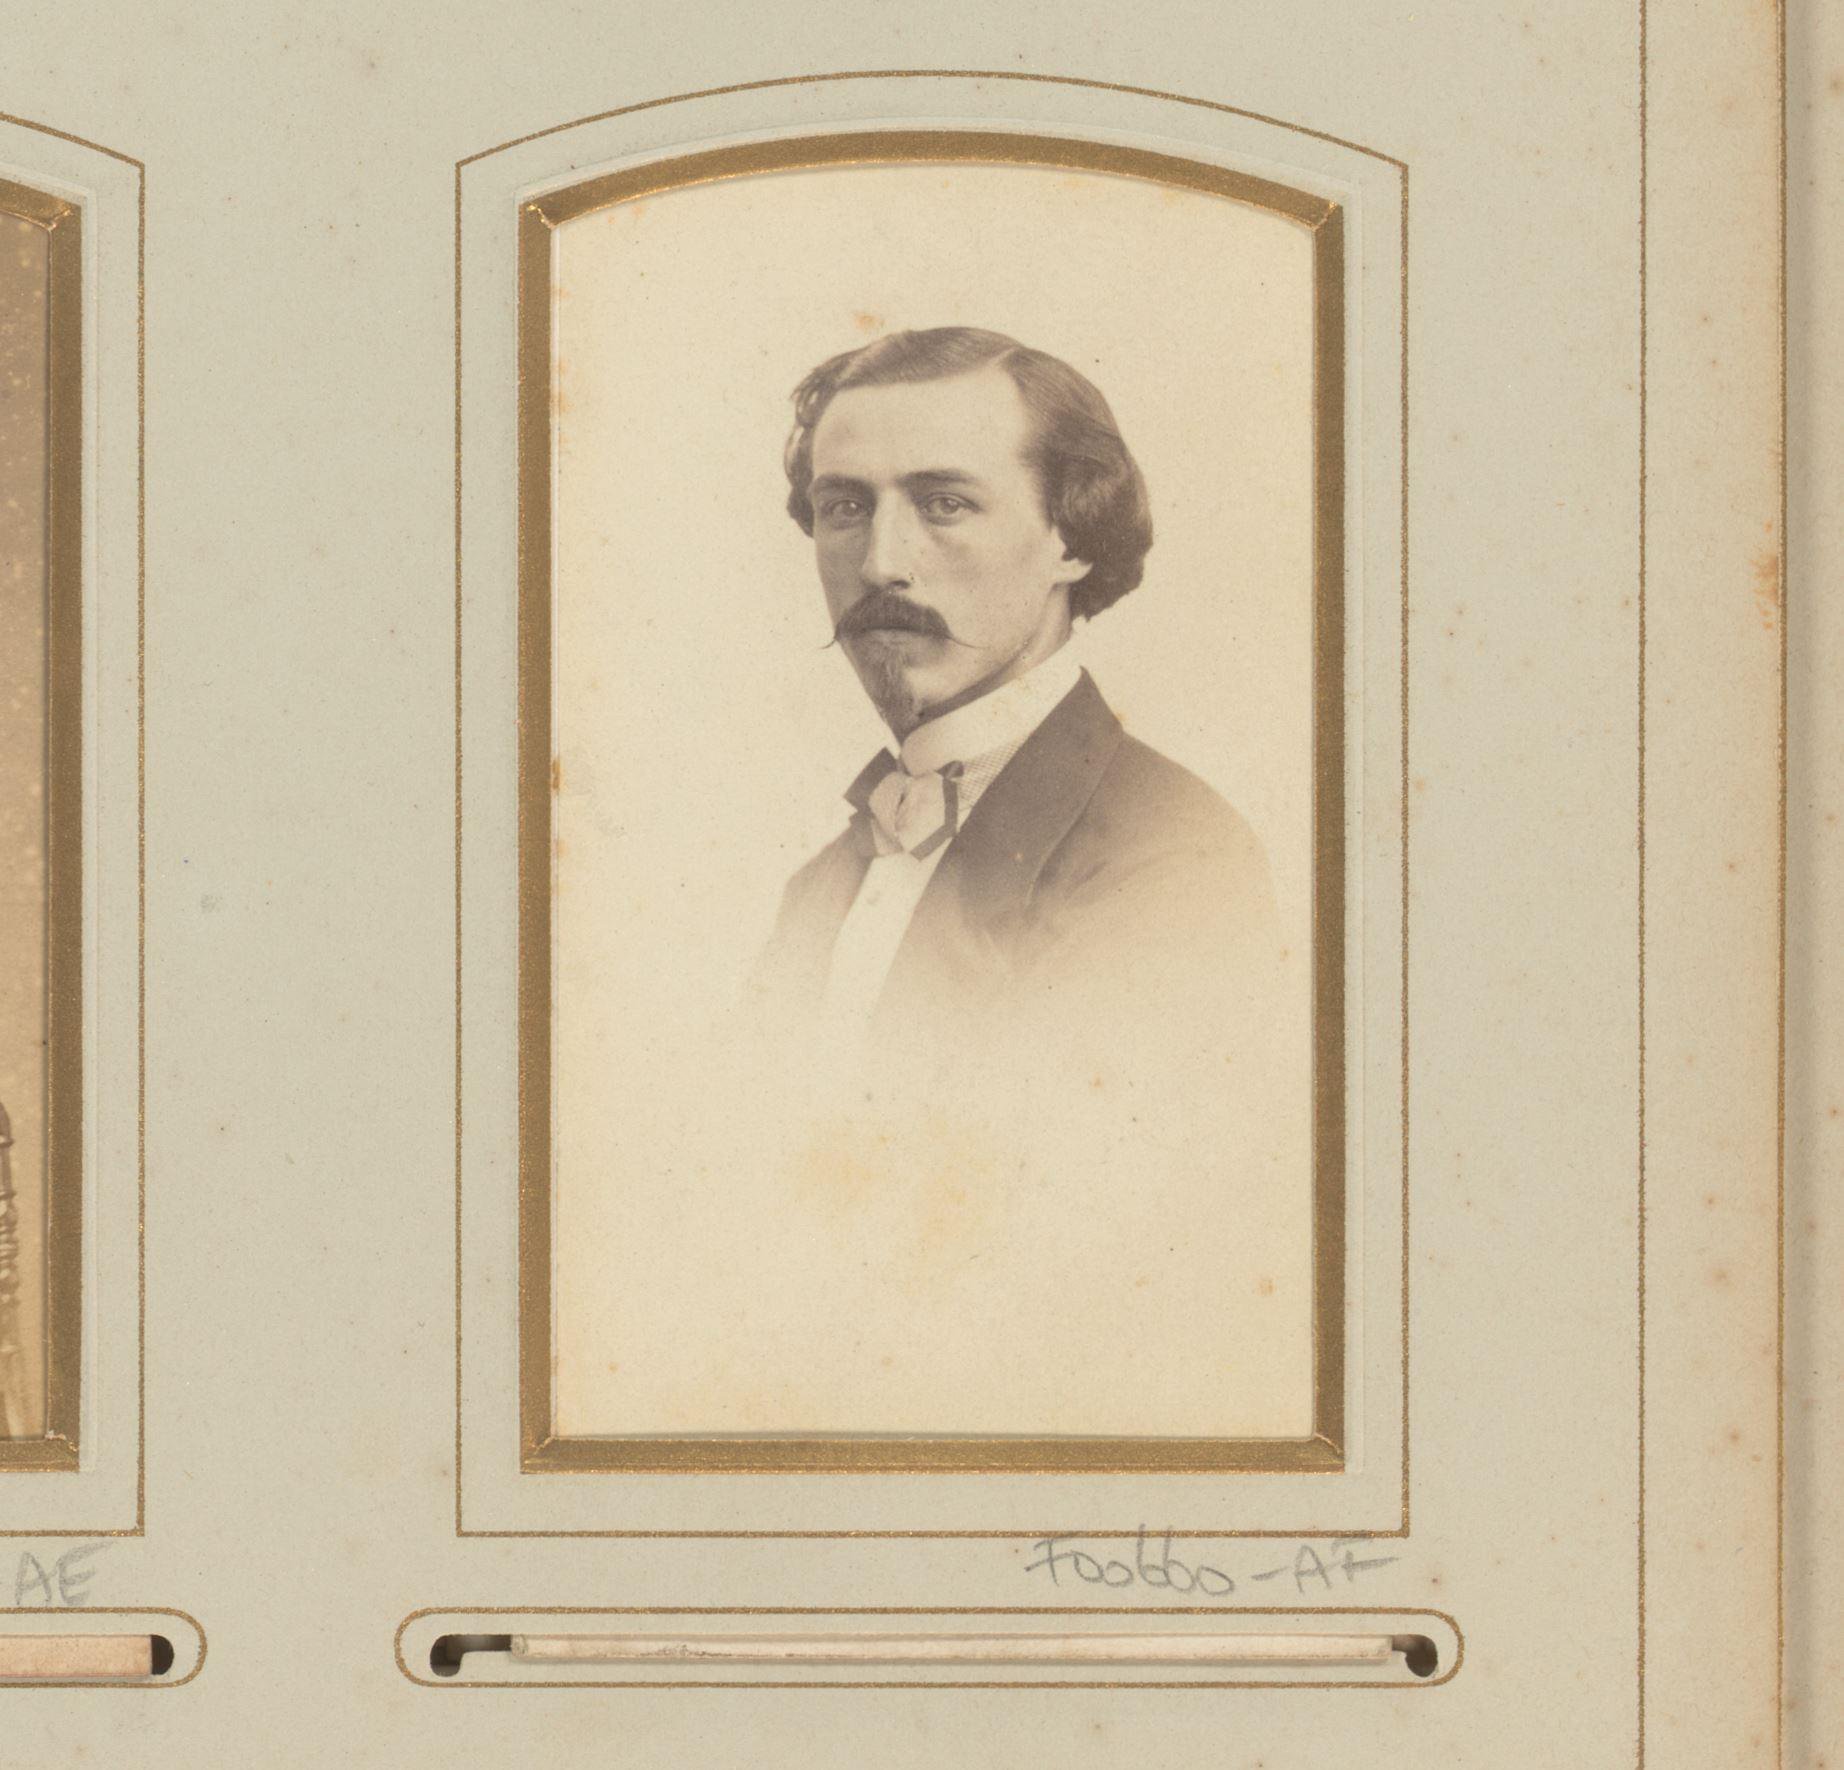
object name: album leaf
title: Portret van een man met snor en sik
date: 1850-1900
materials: cardboard, photographic support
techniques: albumen print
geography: paris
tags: moustache, historical persons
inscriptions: inscription: ‘BISSON FRÈRES/ PHOTOGRAPHES DE S.M. L'ÉMPEREUR/ 8, Rue Garancière,/ près Sant Sulpice/ PARIS’